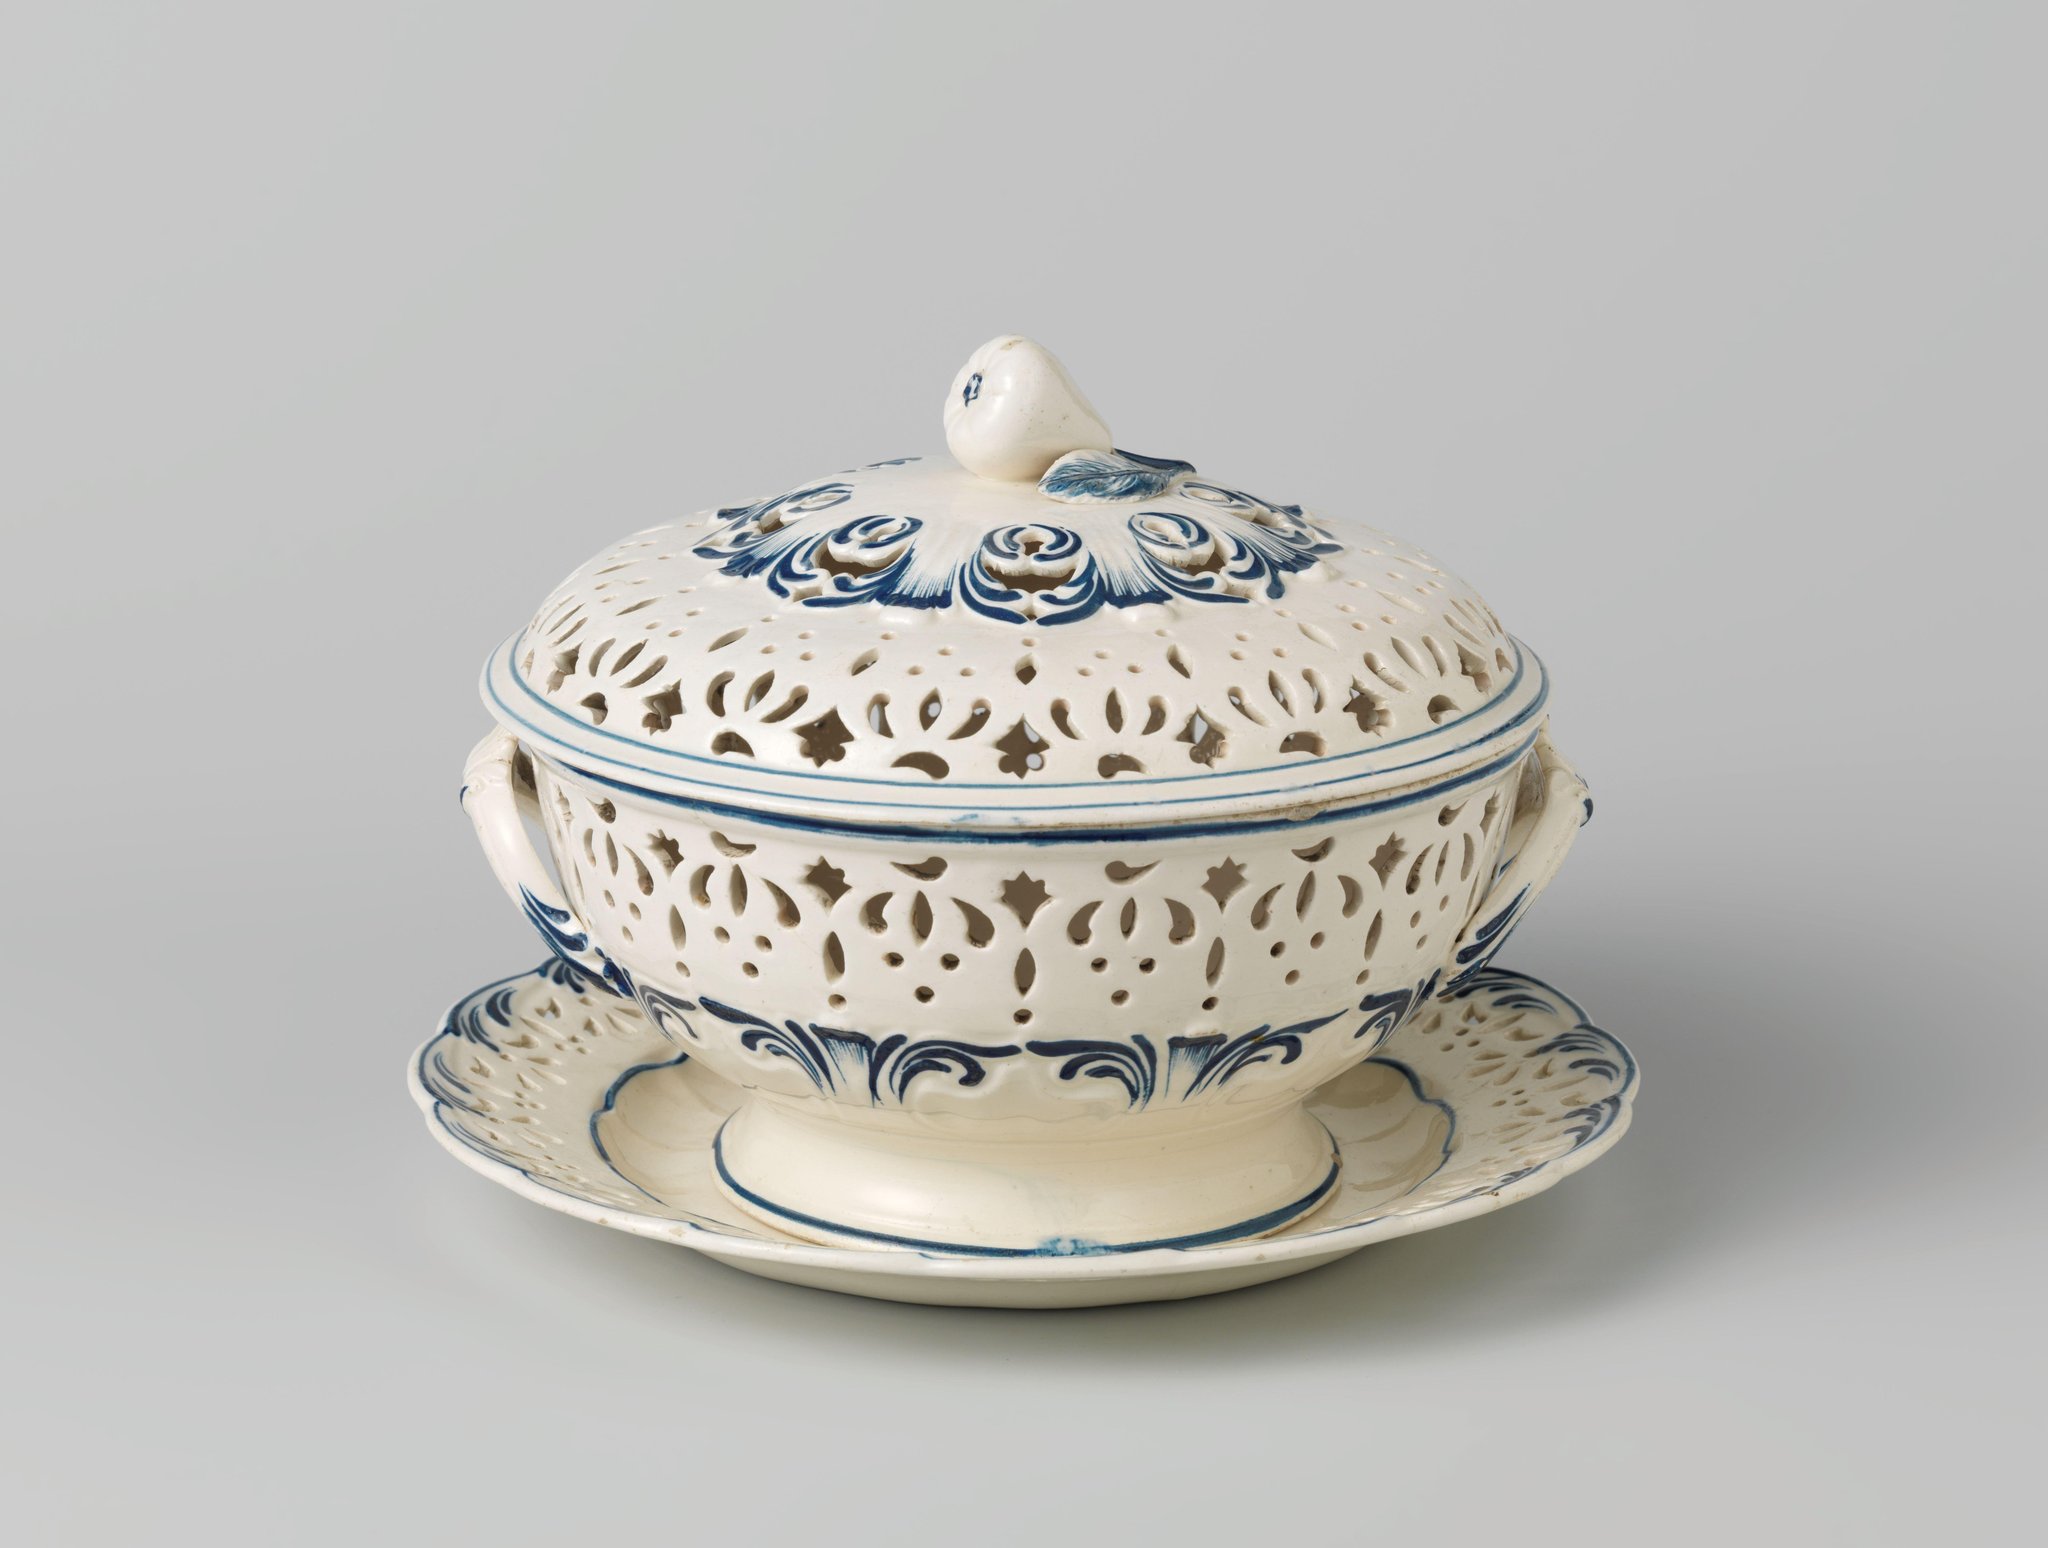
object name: notenmand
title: Mand van Engels hardgebakken aardewerk, Boch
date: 1775-1810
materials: earthenware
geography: luxembourg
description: Notenmand van hardgebakken aardewerk. De bovenrand van de wand is opengewerkt. De mand is in blauw beschilderd. De mand hoort bij een notenmand met onderschotel en deksel (BK-1978-1-A t/m BK-1978-1-C).